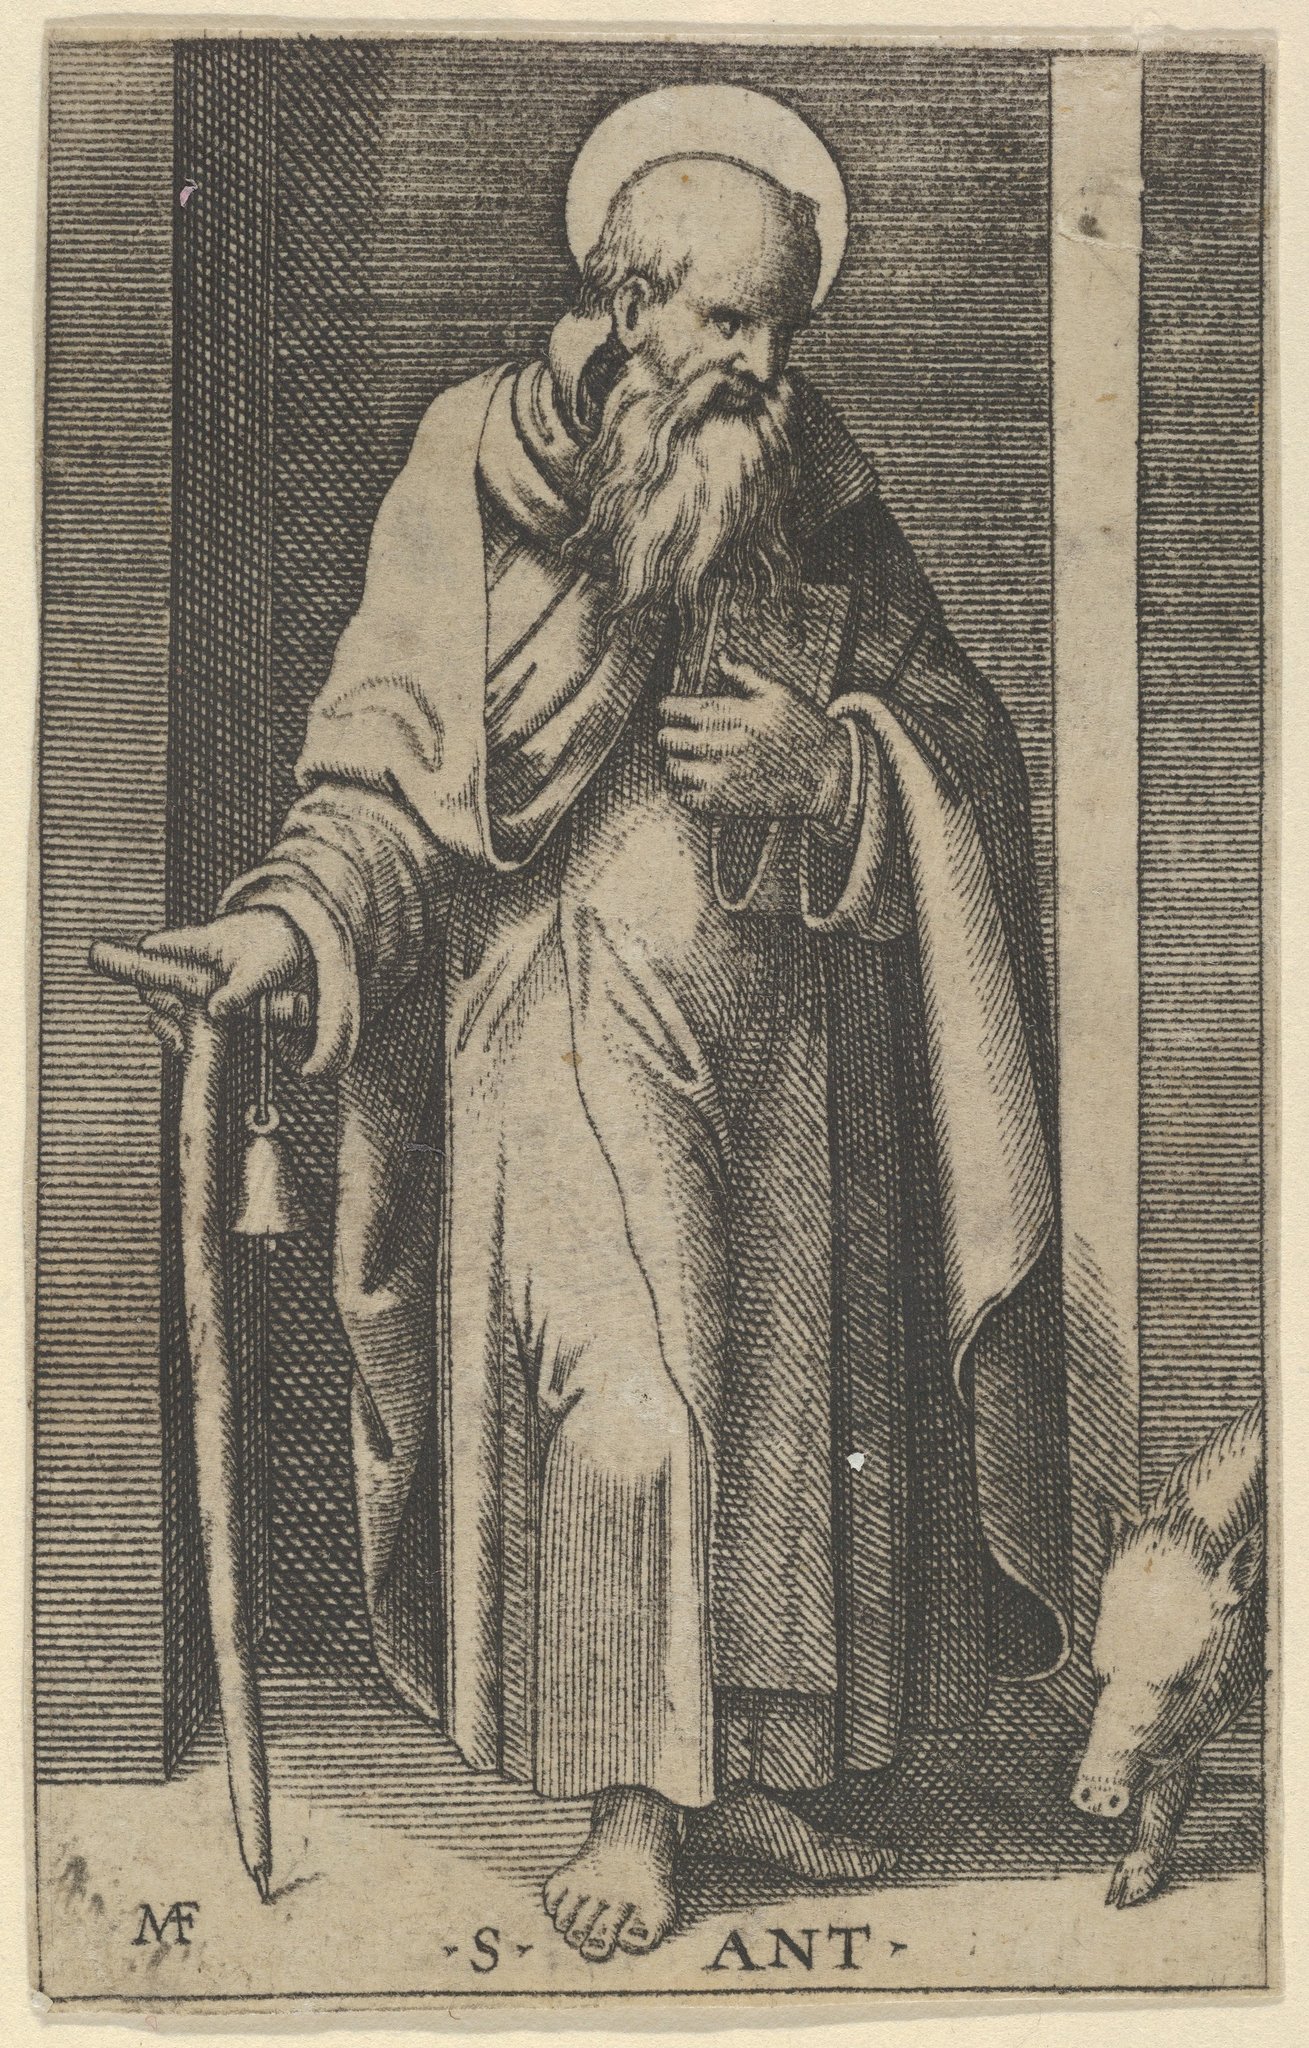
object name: print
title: Saint Anthony, a staff in his right hand, from "Piccoli Santi" (Small Saints)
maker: marcantonio raimondi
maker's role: artist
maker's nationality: italian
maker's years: 1475-1534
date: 1500-1527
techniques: engraving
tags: musical instruments,boars,saint anthony